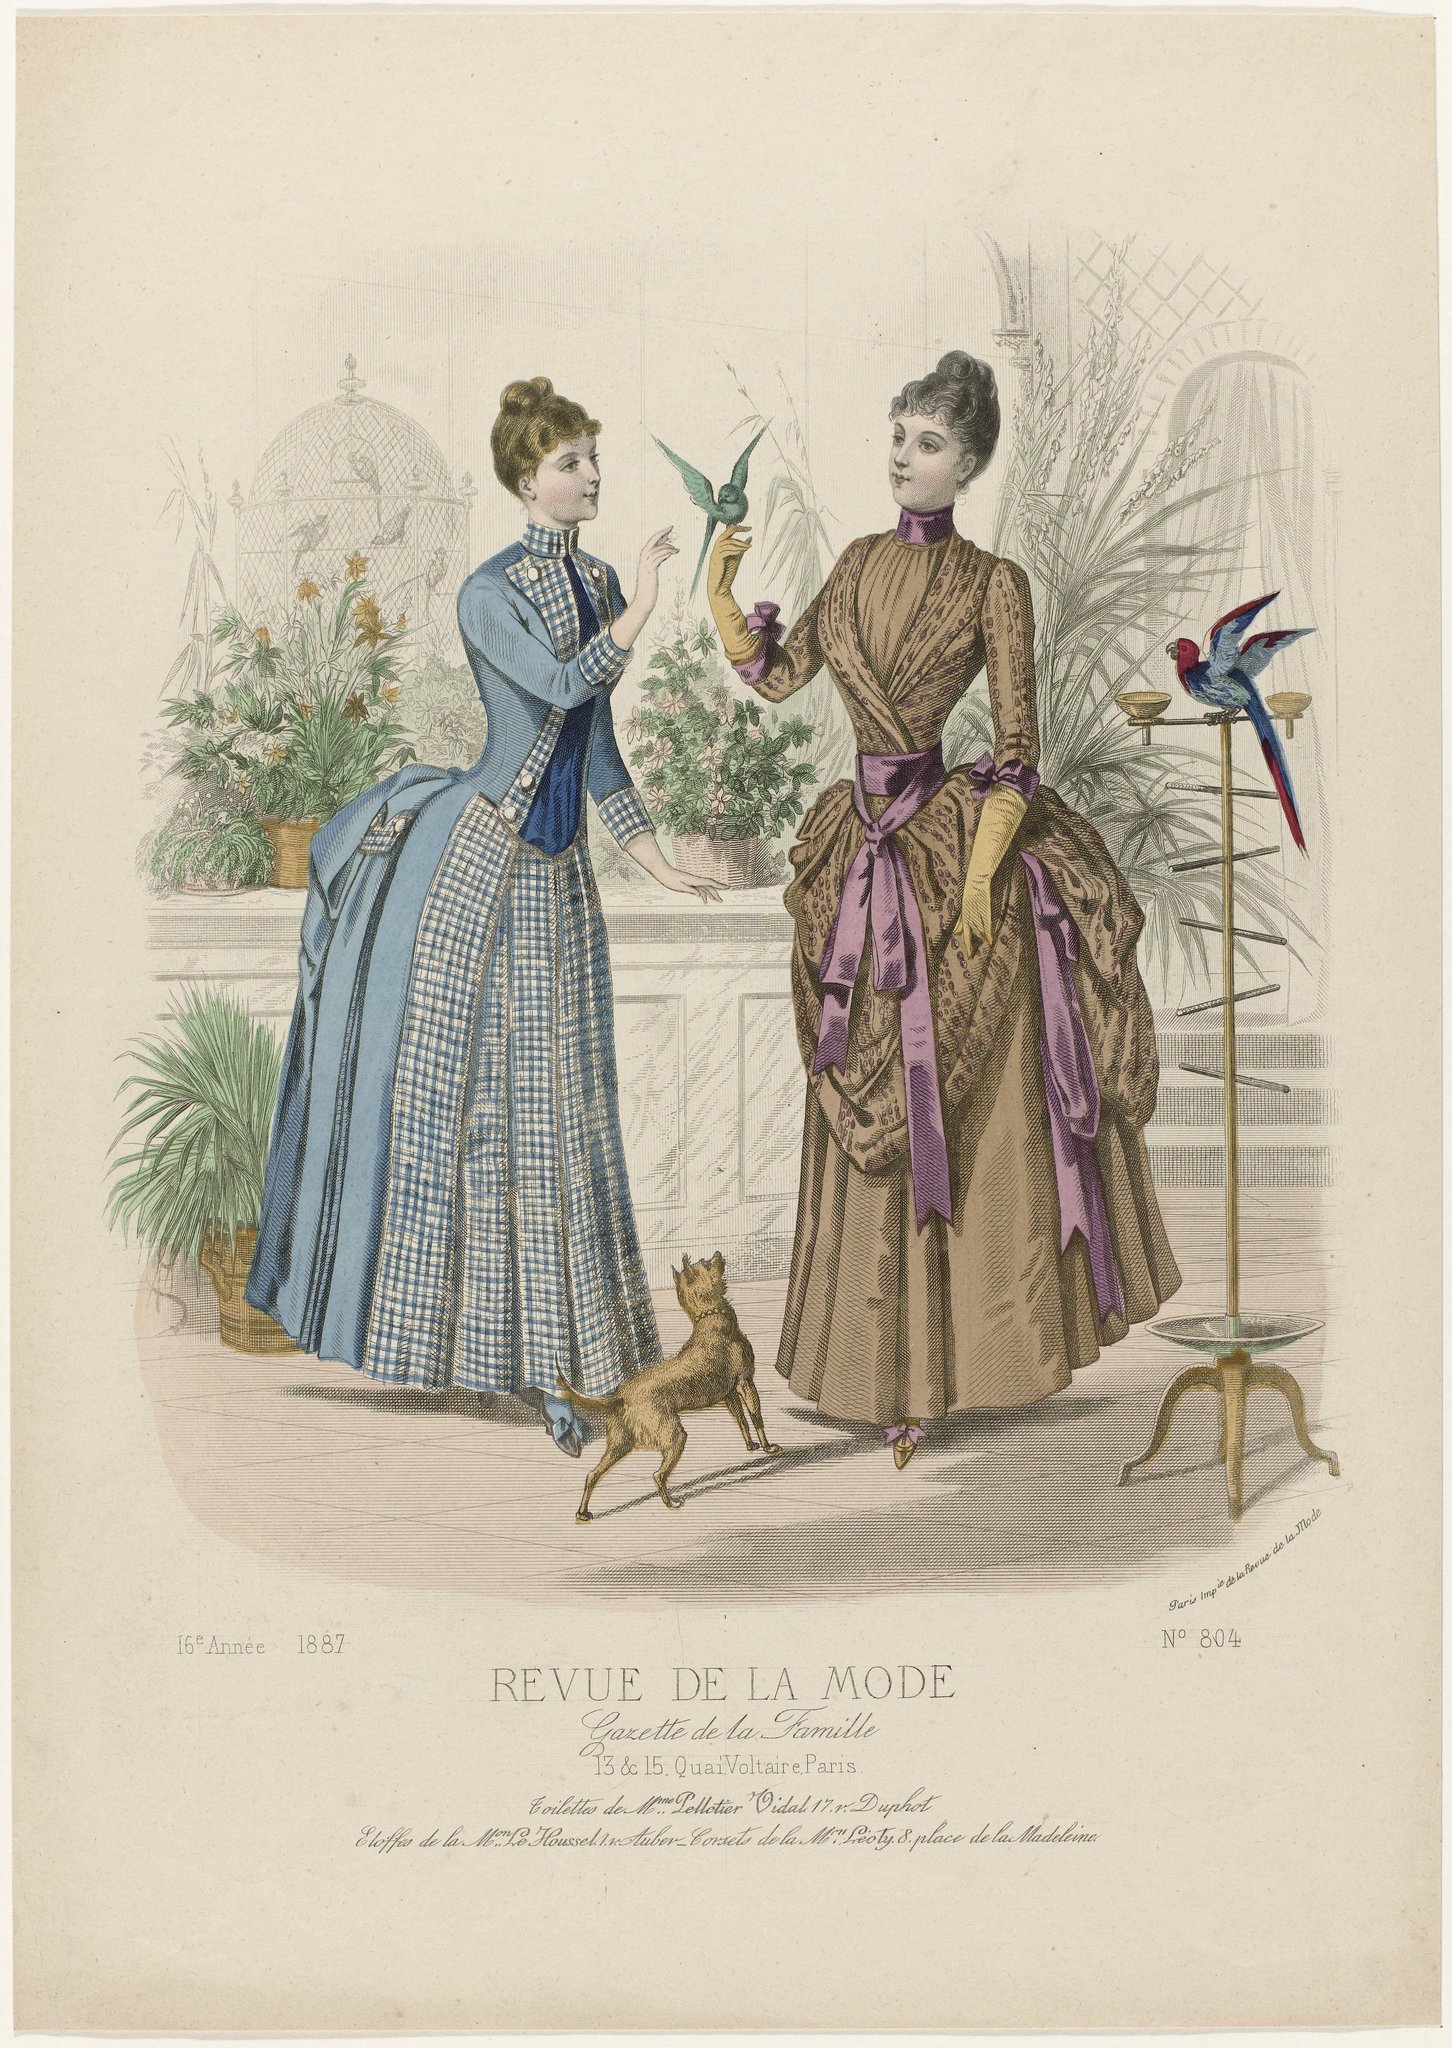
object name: fashion print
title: Revue de la Mode, Gazette de la Famille, dimanche 29 mai 1887, 16e Année, No. 804: Toilettes de Mme Pelletier Vidal (...)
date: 1887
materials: paper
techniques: engraving, hand coloring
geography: paris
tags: birds in a large cage, aviary, border, ribbon, braid (+ women's clothes), ornamental birds: parrot, fashion plates, dress, gown (+ women's clothes), dog, belt, girdle, waistband (+ women's clothes)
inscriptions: address: ‘13 & 15, Quai Voltaire Paris’, title: ‘REVUE DE LA MODE / Gazette de la Famille’, caption: ‘Toilettes de Mme Pelletier Vidal 17, r. Duphot. Etoffes de la M.on Le Houssel, 1, r. Auber_ Corsets de la M.on Léoty, 8, place de la Madeleine.’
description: Twee vrouwen in een serre met een vogelkooi, twee papegaaien, vogelstandaard en hond. Links: 'toilette' van lichtblauwe wol en geruite wol. Rechts: 'toilette' van beige wollen mousseline, beige en paarse pékin, beige gaas en paarse linten. Paars ceintuur, aan de voorzijde gestrikt. Volgens het onderschrift: 'toilettes' van Pelletier Vidal. Hieronder een regel reclametekst voor verschillende producten. Prent uit het modetijdschrift Revue de la Mode (1872-1913). Uitgebreide beschrijving van de kleding op pagina 174 "PLANCHE COLORIÉE".